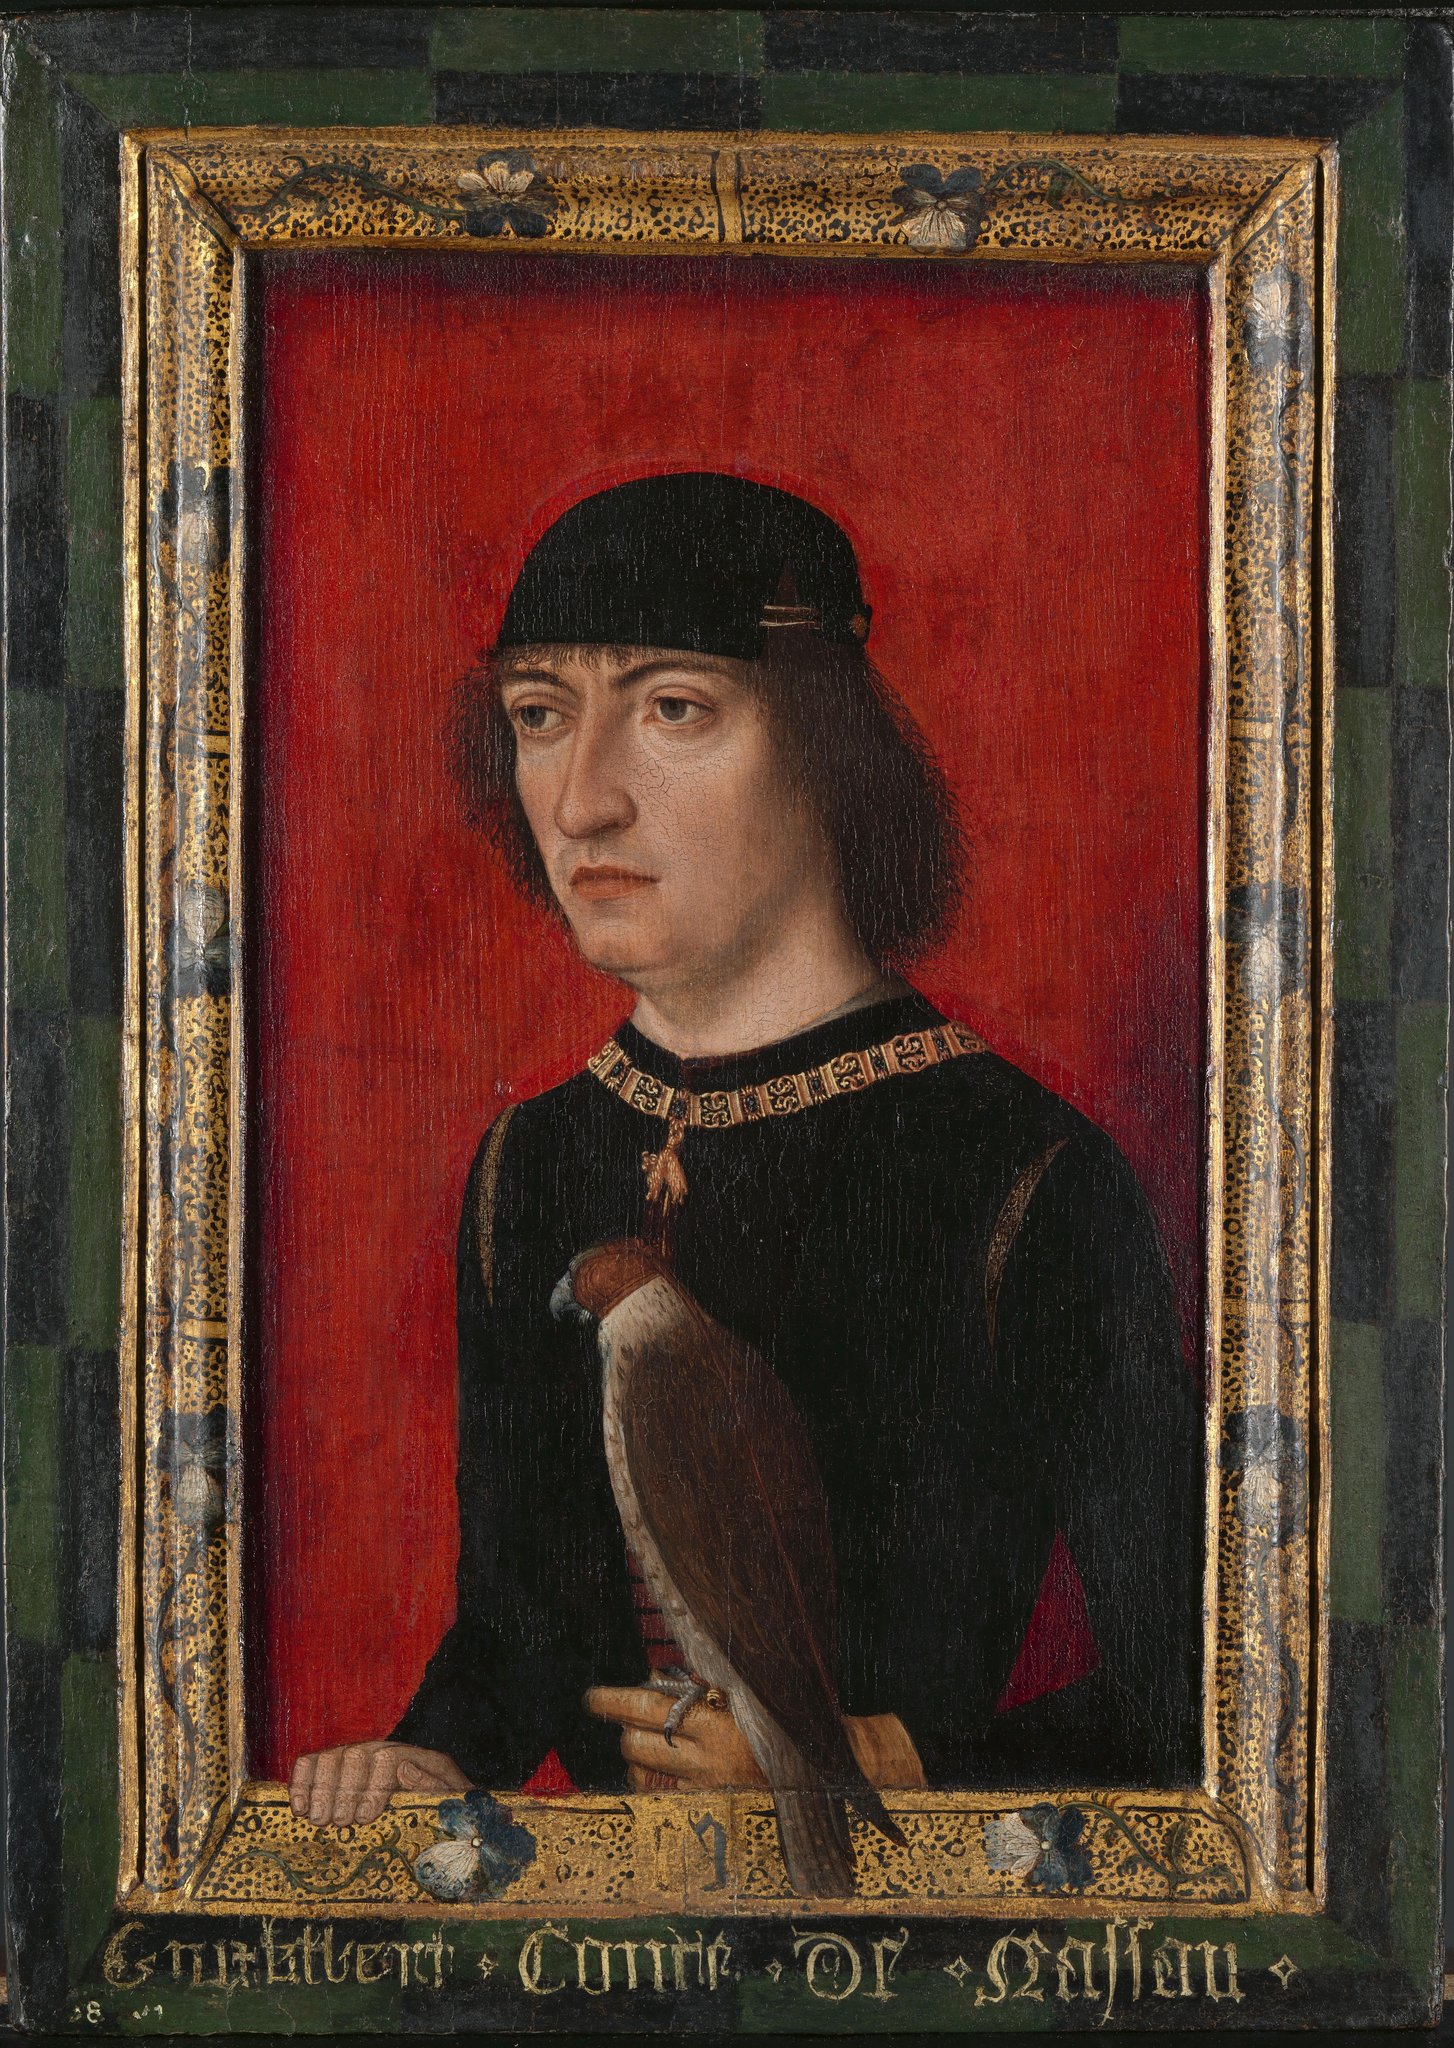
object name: painting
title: Engelbert II van Nassau Master of the Portraits of Princes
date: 1480-1490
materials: oil, paint, panel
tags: brussels, predatory birds: falcon, historical persons, knighthood order of the golden fleece - insignia of a knighthood order, e.g.: badge, chain (with name of order)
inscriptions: inscription, bottom of the frame: ‘Engelbert Conte de Nassau’, date, top frame: ‘1487’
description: Engelbert, Count of Nassau, was one of the most prominent nobles of the Duchy of Burgundy. That he belonged to the upper echelons is evident from the prestigious chain of the Order of the Golden Fleece around his neck and the gyrfalcon on his hand. Hunting with this bird of prey was an exclusive pastime and largely restricted to the high nobility.